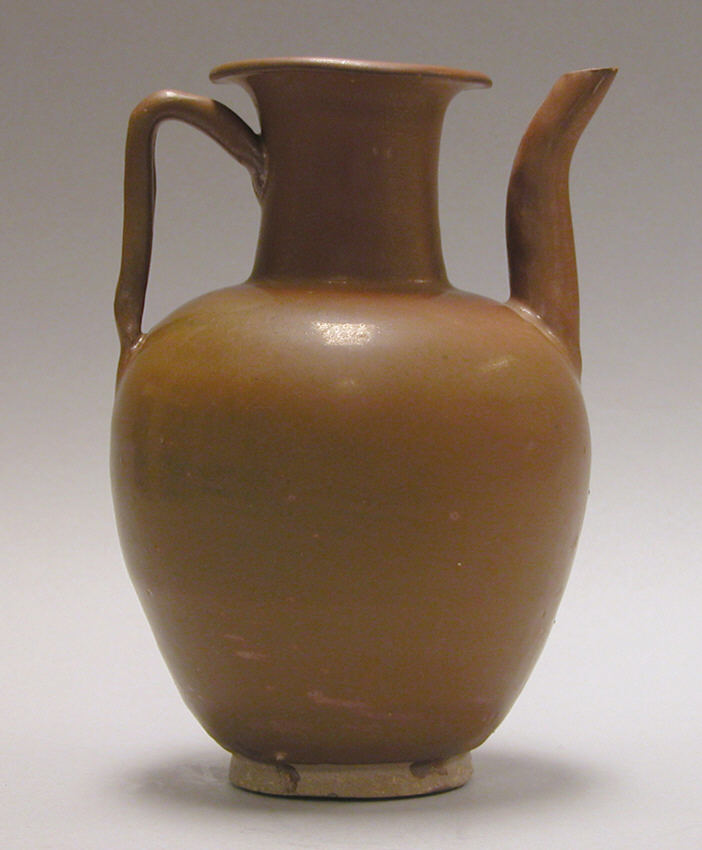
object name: ewer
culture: chinese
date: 1001-1100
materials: glaze, stoneware